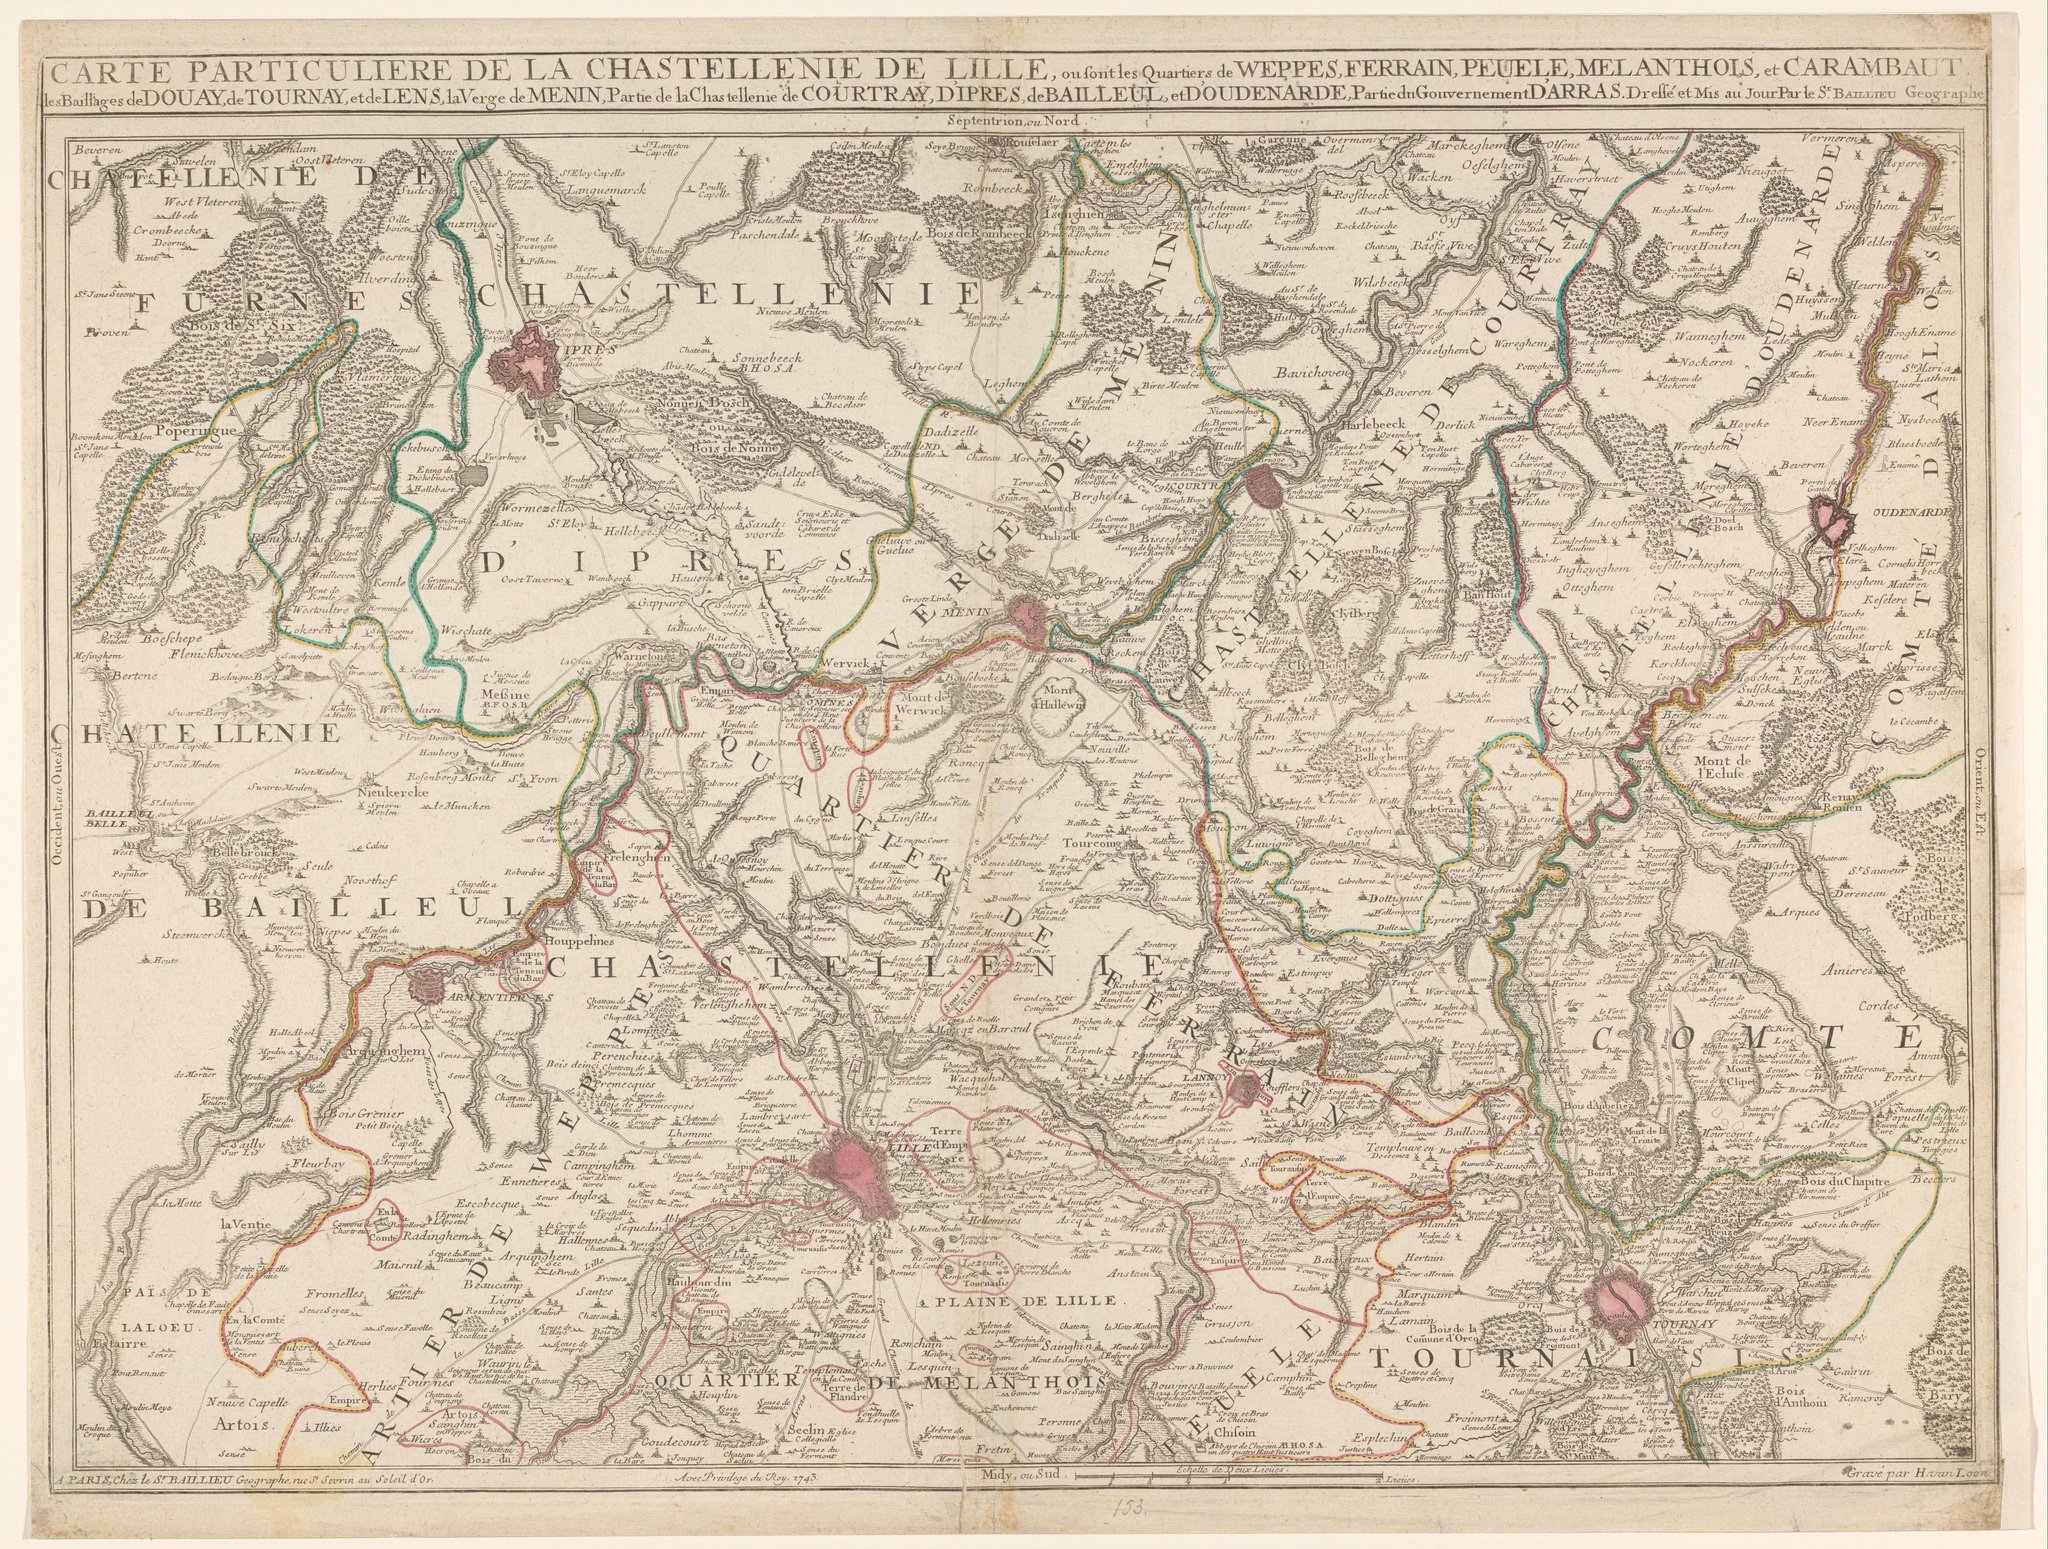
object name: print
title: Kaart van Frans-Vlaanderen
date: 1743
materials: paper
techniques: etching, hand coloring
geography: paris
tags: maps of separate countries or regions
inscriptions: collector's mark: Lugt 2228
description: Kaart van Frans-Vlaanderen. Boven de kaart een balk met de titel. In een balk onder de kaart een schaalstok: Echelle de Deux Lieues.